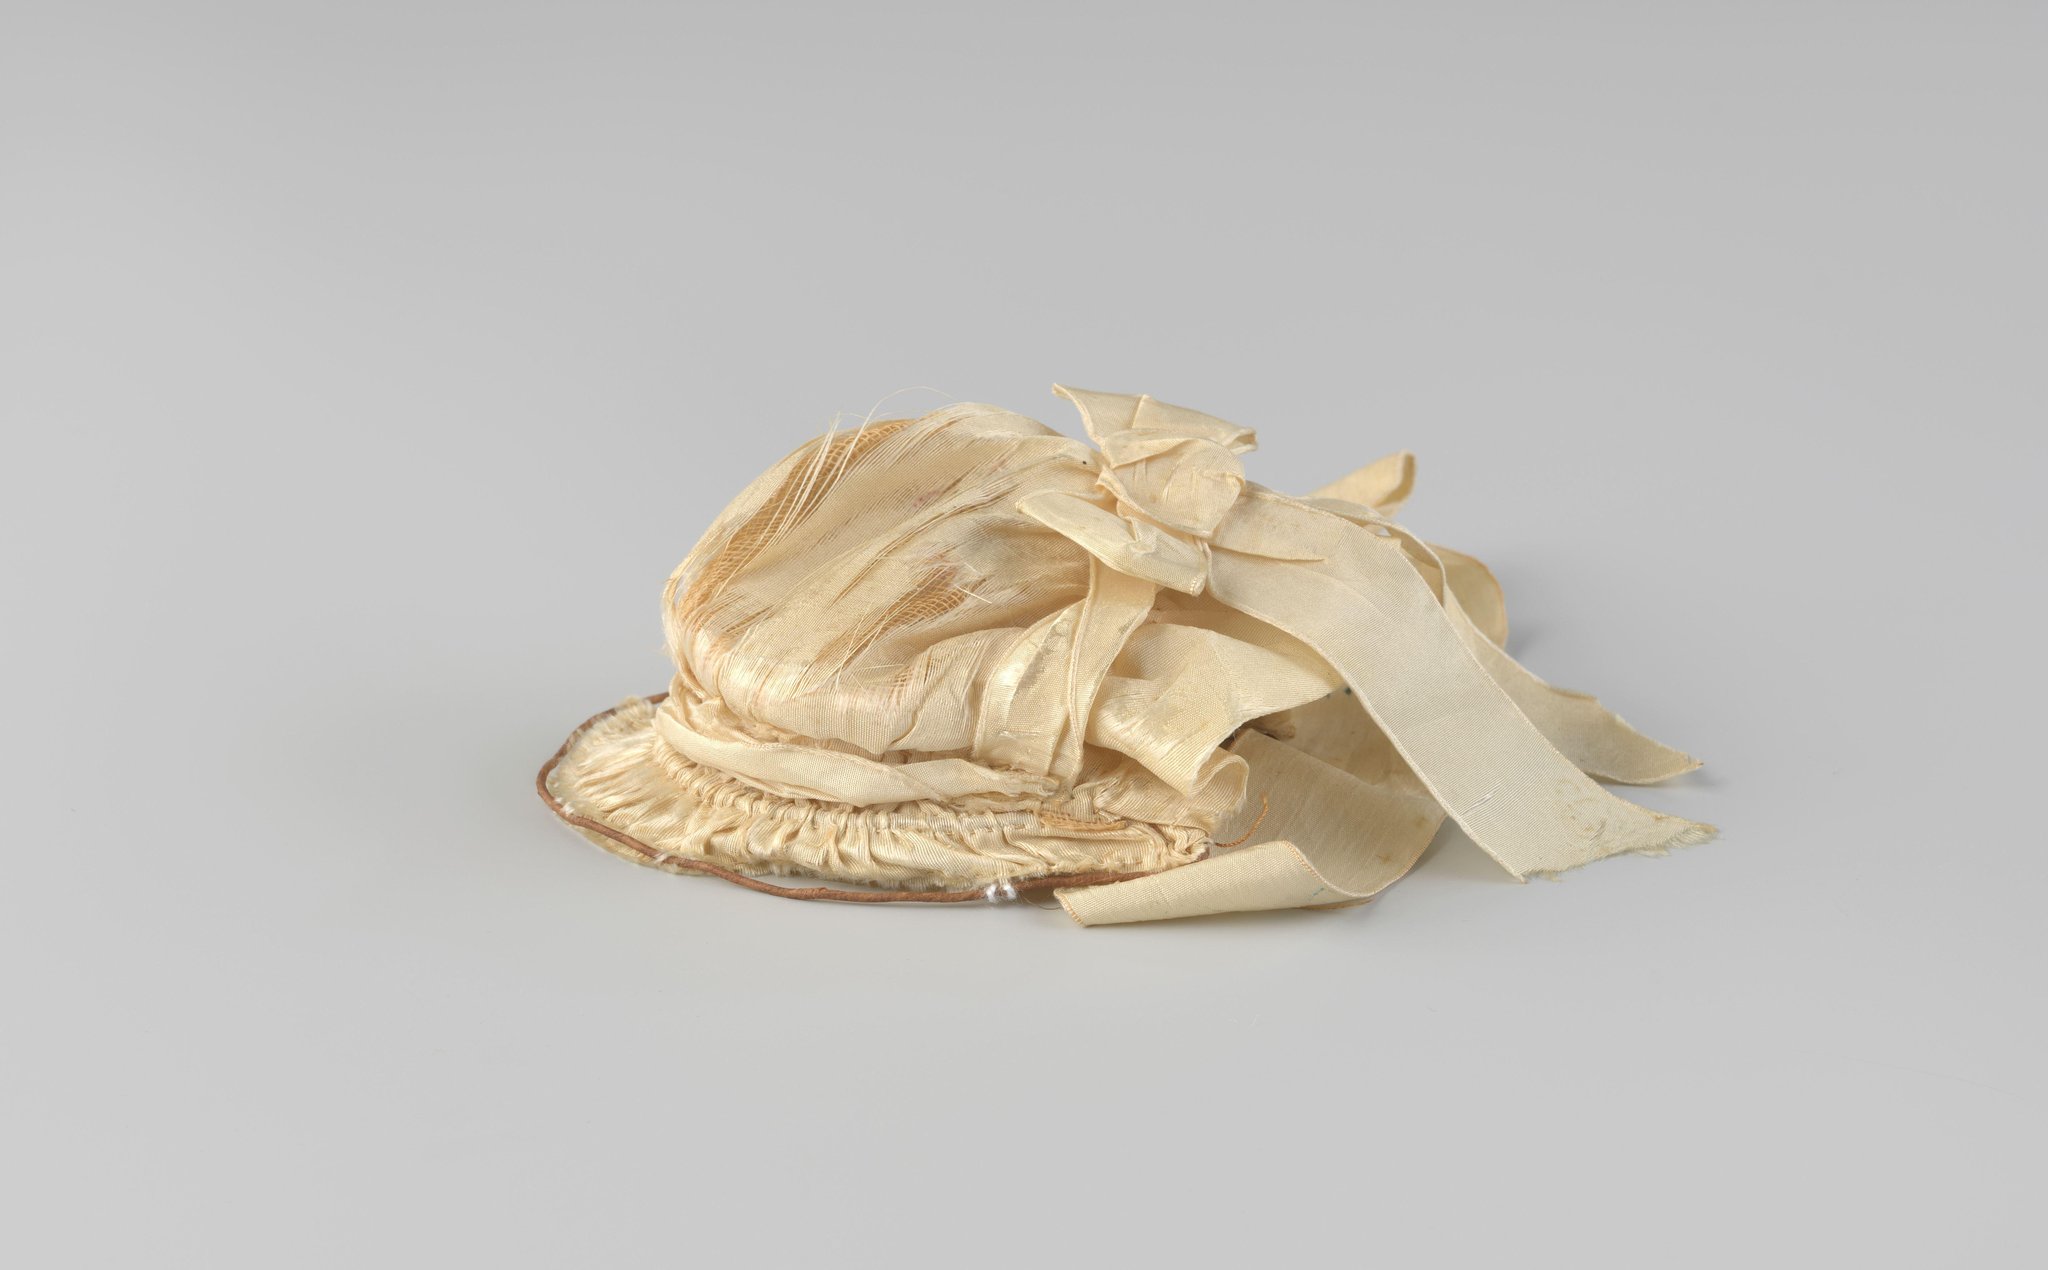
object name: doll's clothing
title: Luifelhoed met gerimpelde rand en strik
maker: Anonymous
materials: silk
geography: netherlands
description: Luifelhoed van witte zijde met gerimpelde rand en een strik aan de achterkant.